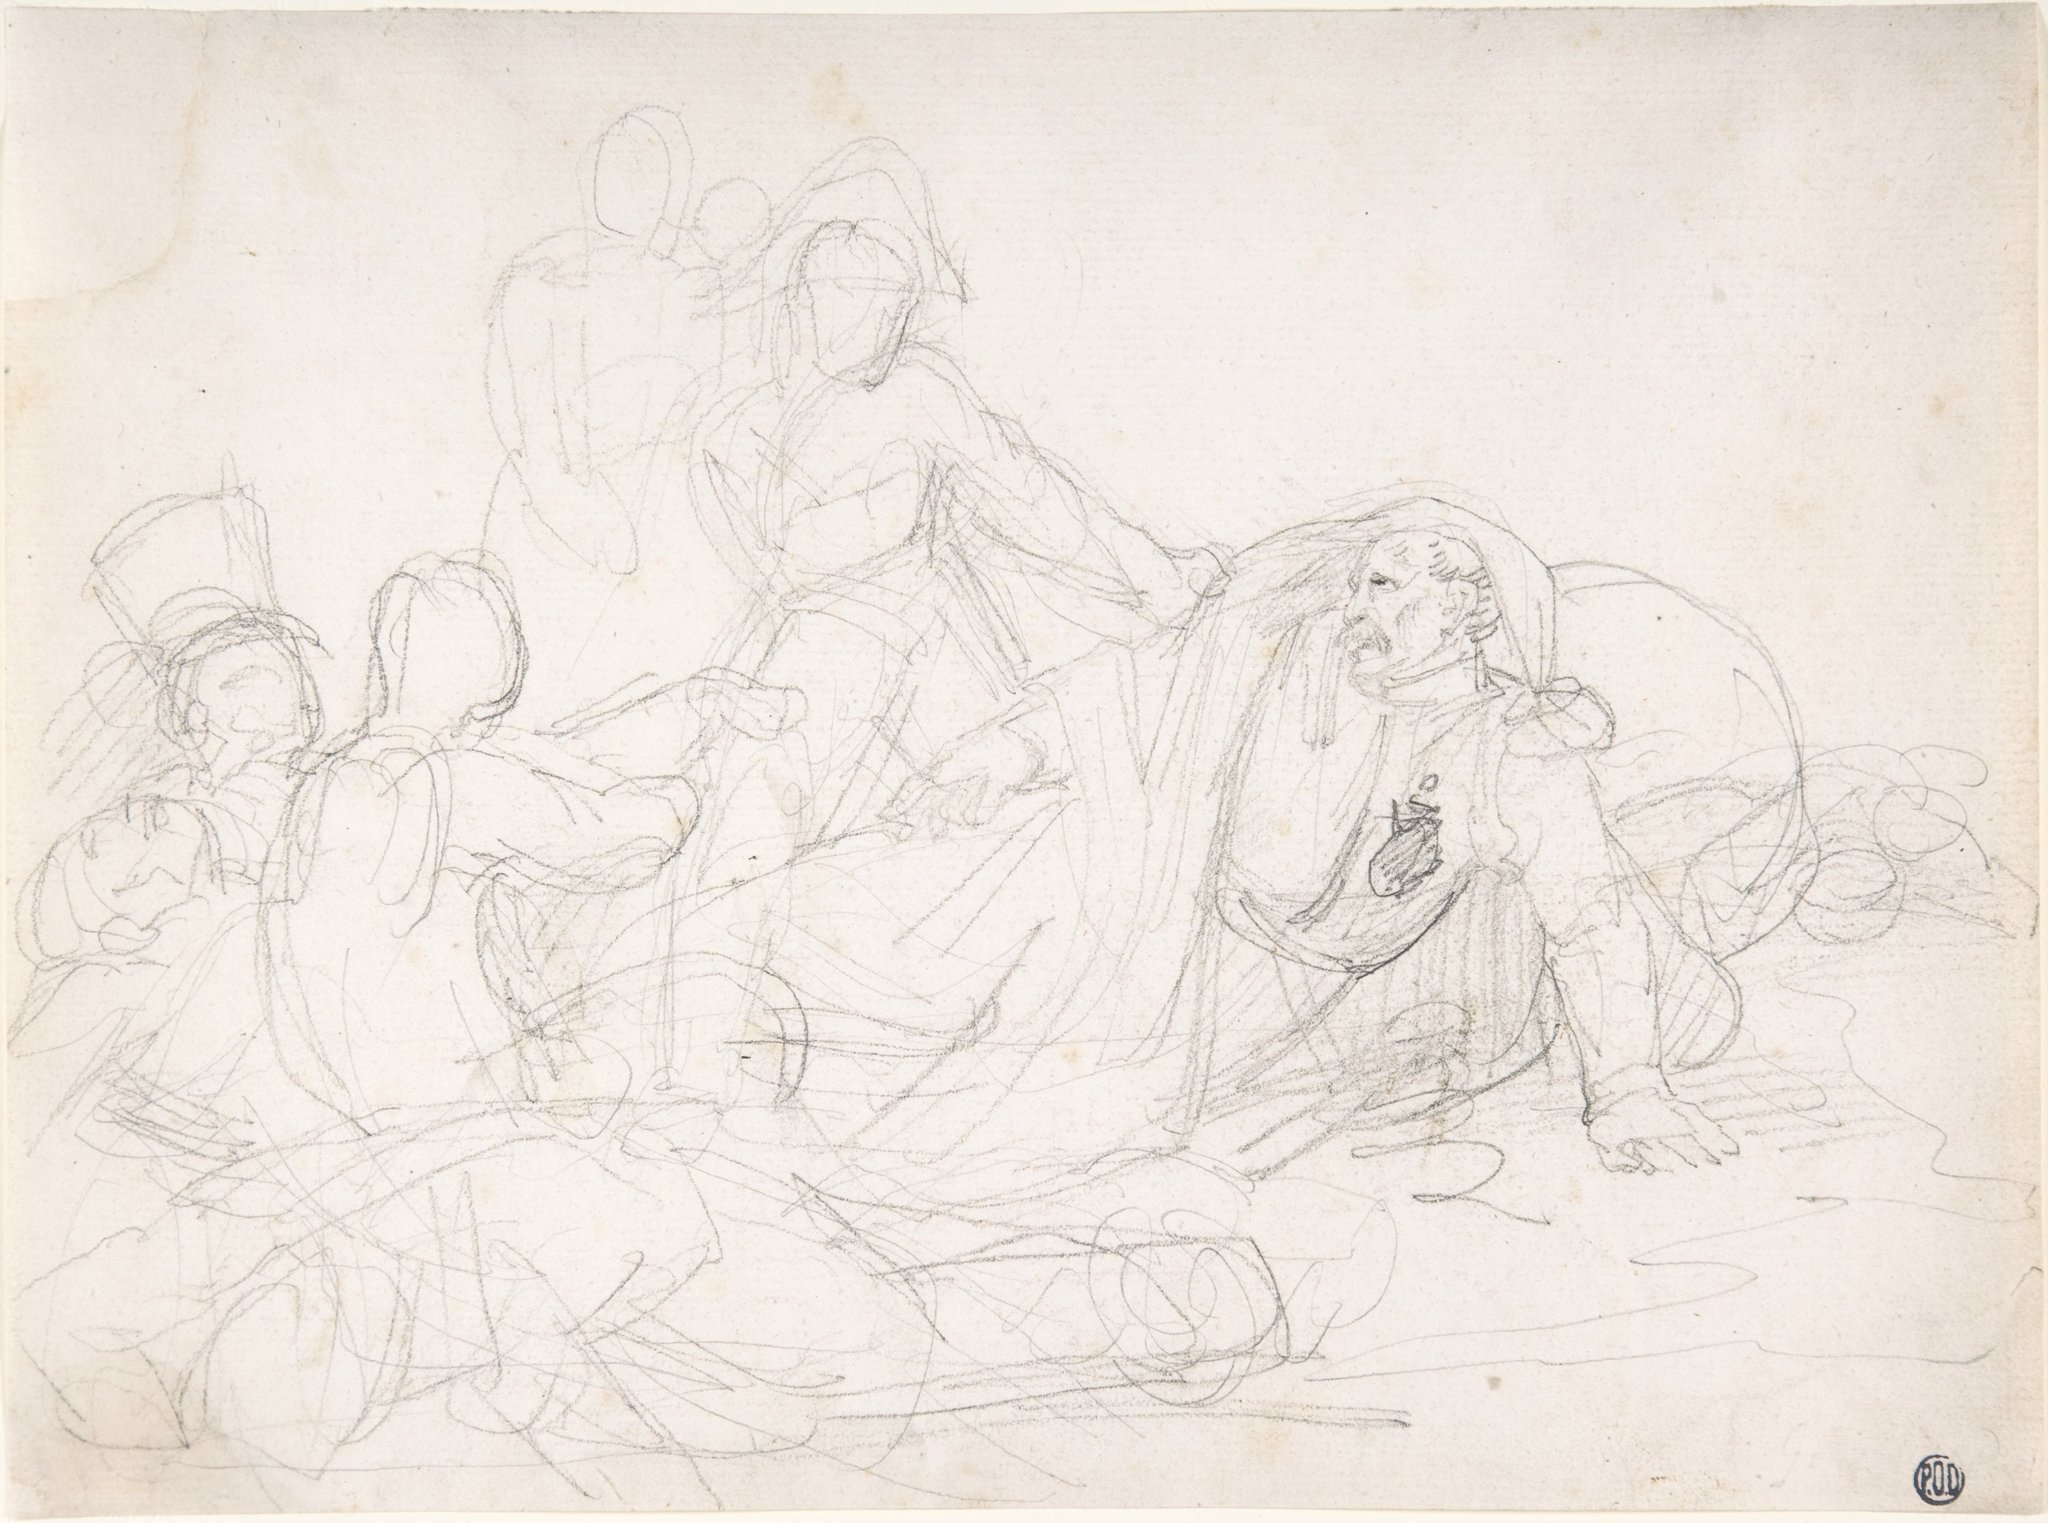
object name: drawing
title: Fallen Soldiers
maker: jean louis andré théodore géricault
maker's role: artist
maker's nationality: french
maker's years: 1791-1824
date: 1818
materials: graphite, paper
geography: france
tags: soldiers,men